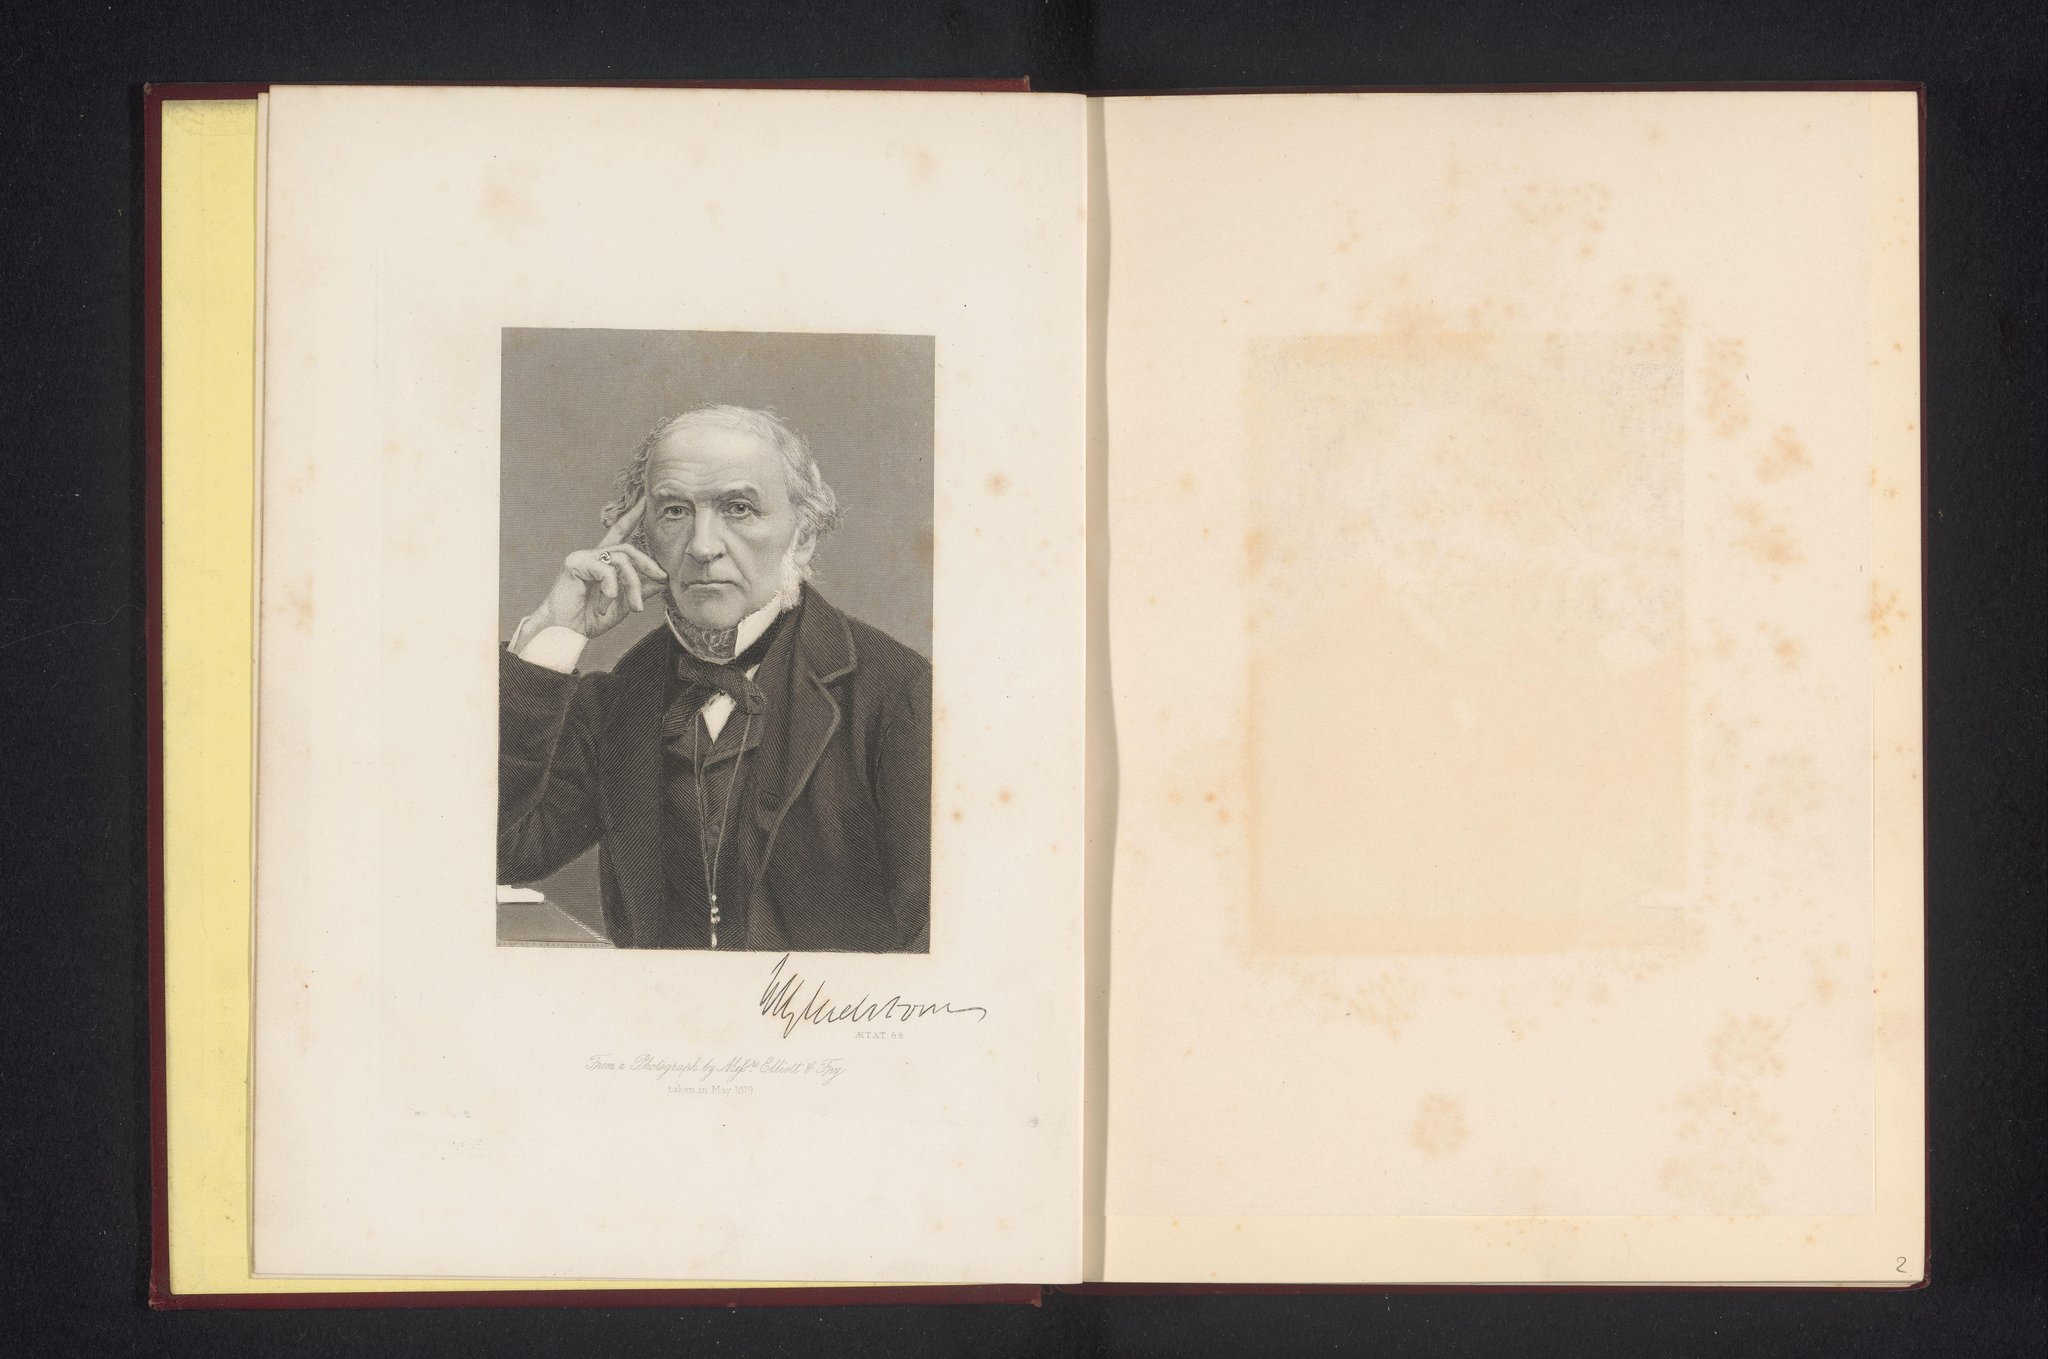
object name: page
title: Fotoreproductie van een prent, voorstellende een portret van William Ewart Gladstone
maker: Anonymous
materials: paper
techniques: photoaquatint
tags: politician, politician, e.g. party leader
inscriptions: inscription: ‘aetat 69’